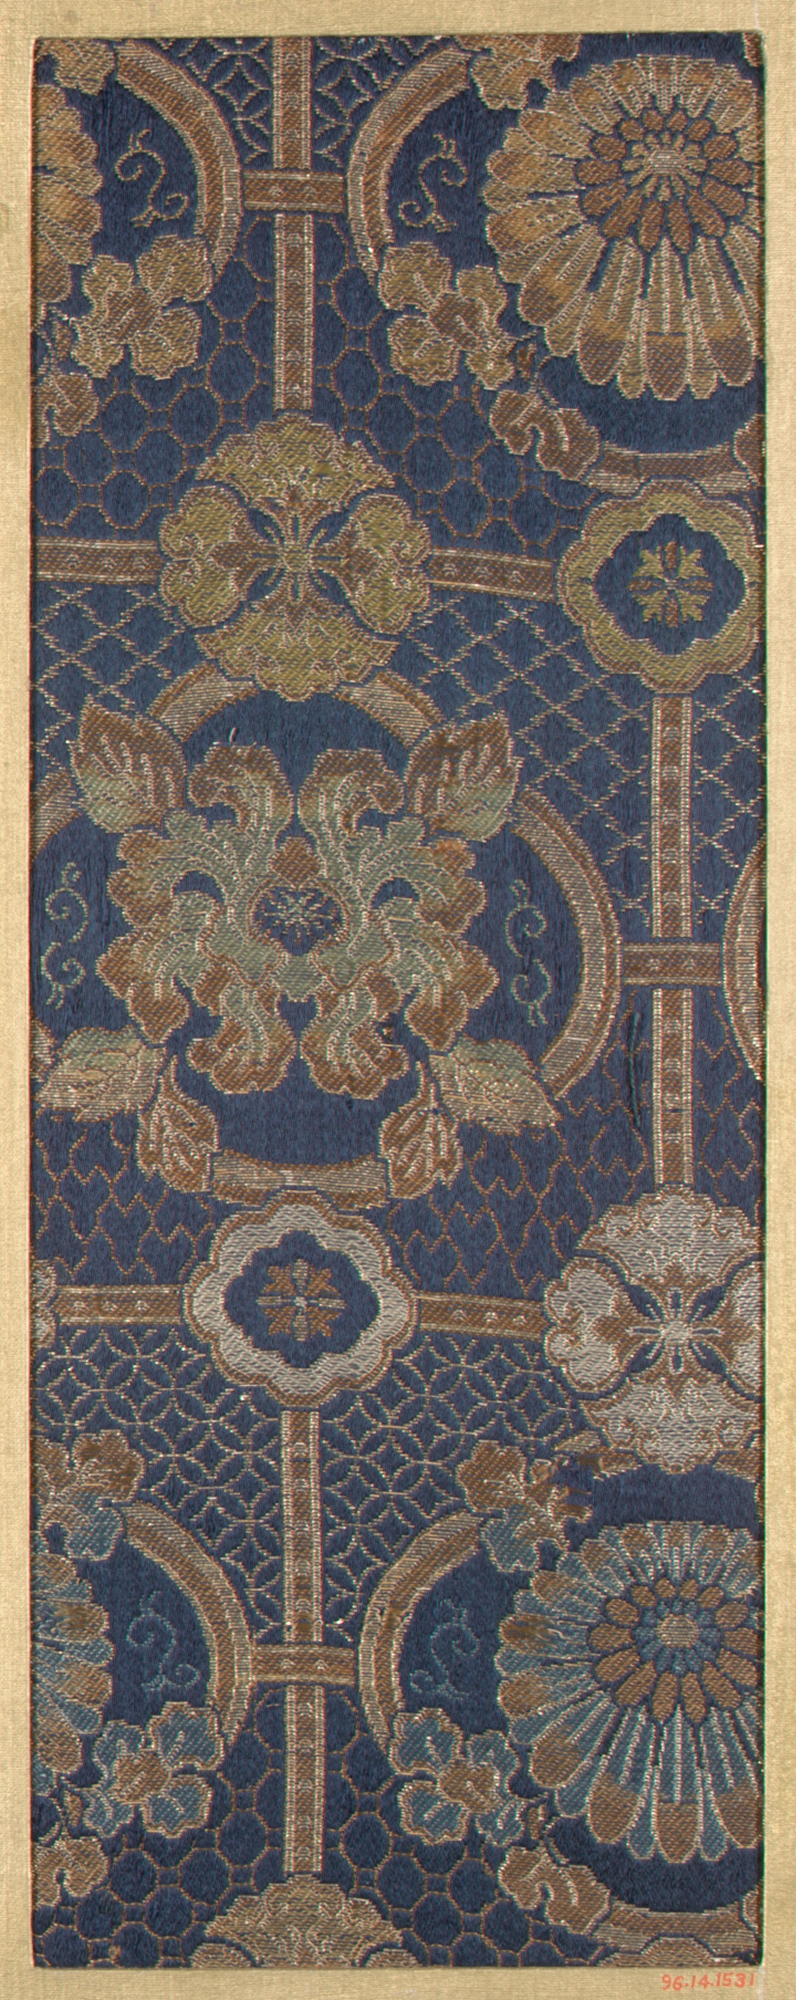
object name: piece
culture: japanese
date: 1701-1900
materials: silk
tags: flowers